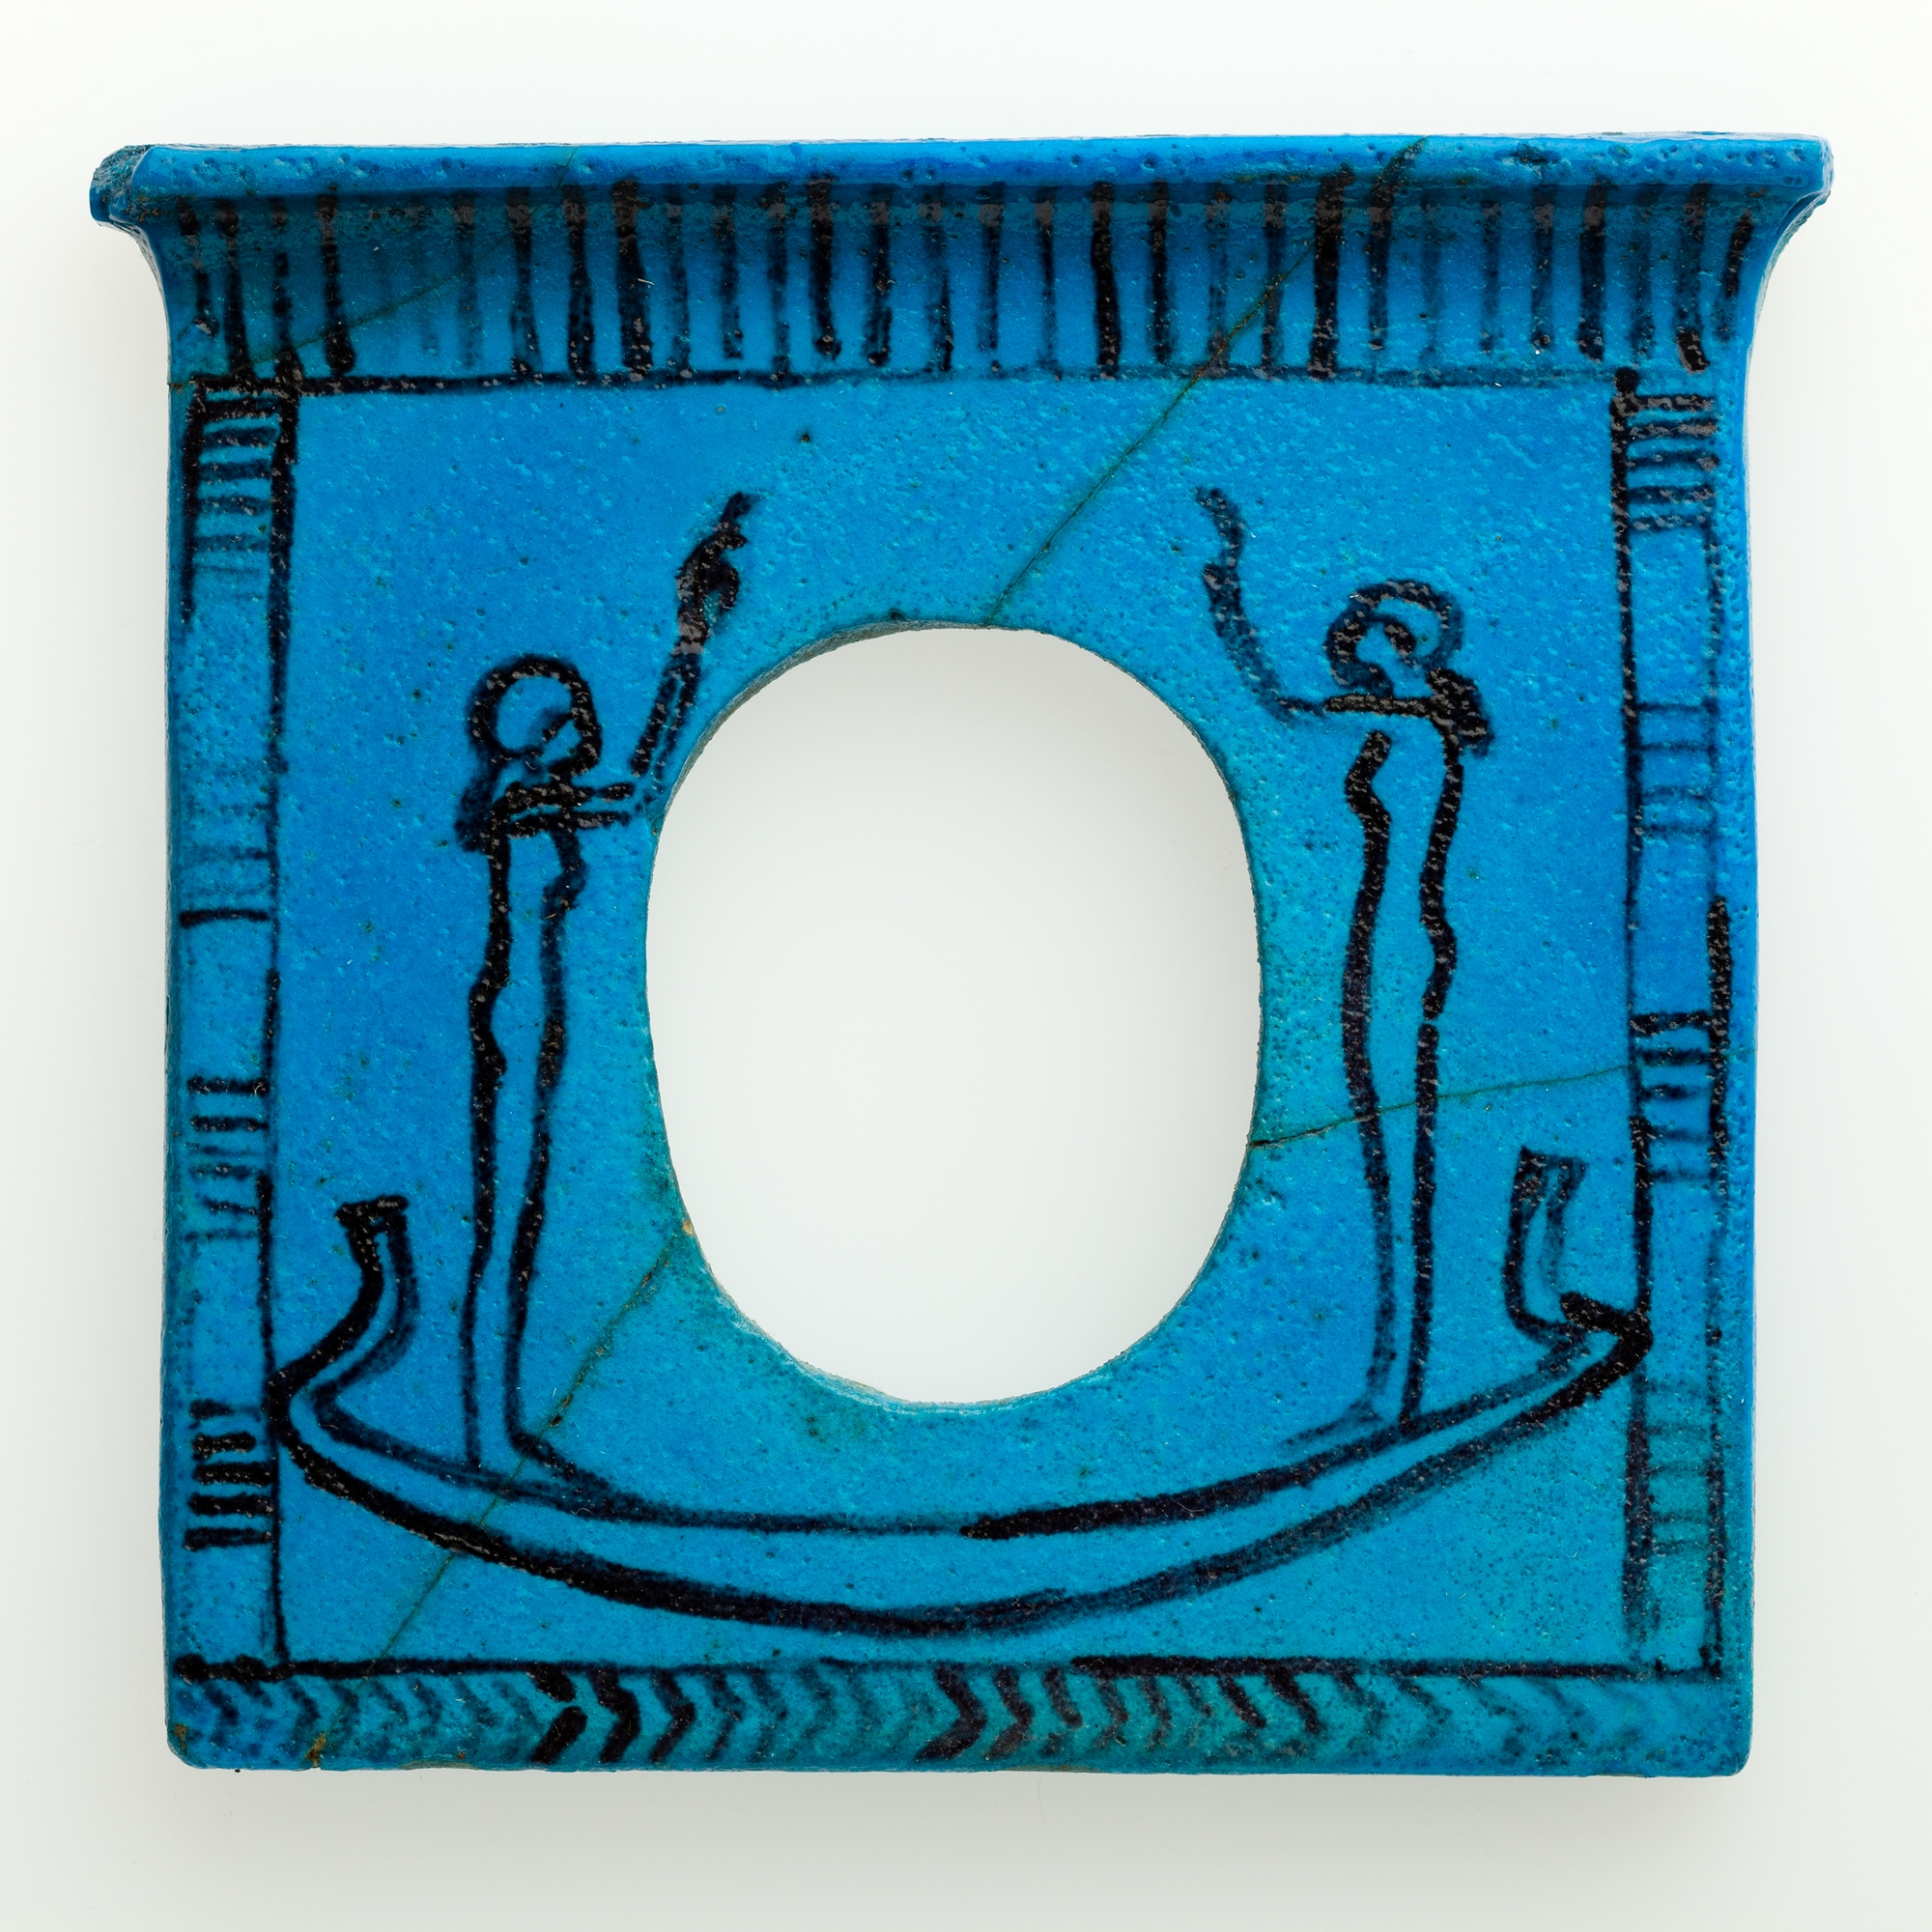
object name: pectoral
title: Funerary Pectoral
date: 1295-664 BCE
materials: faience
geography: egypt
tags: women,boats